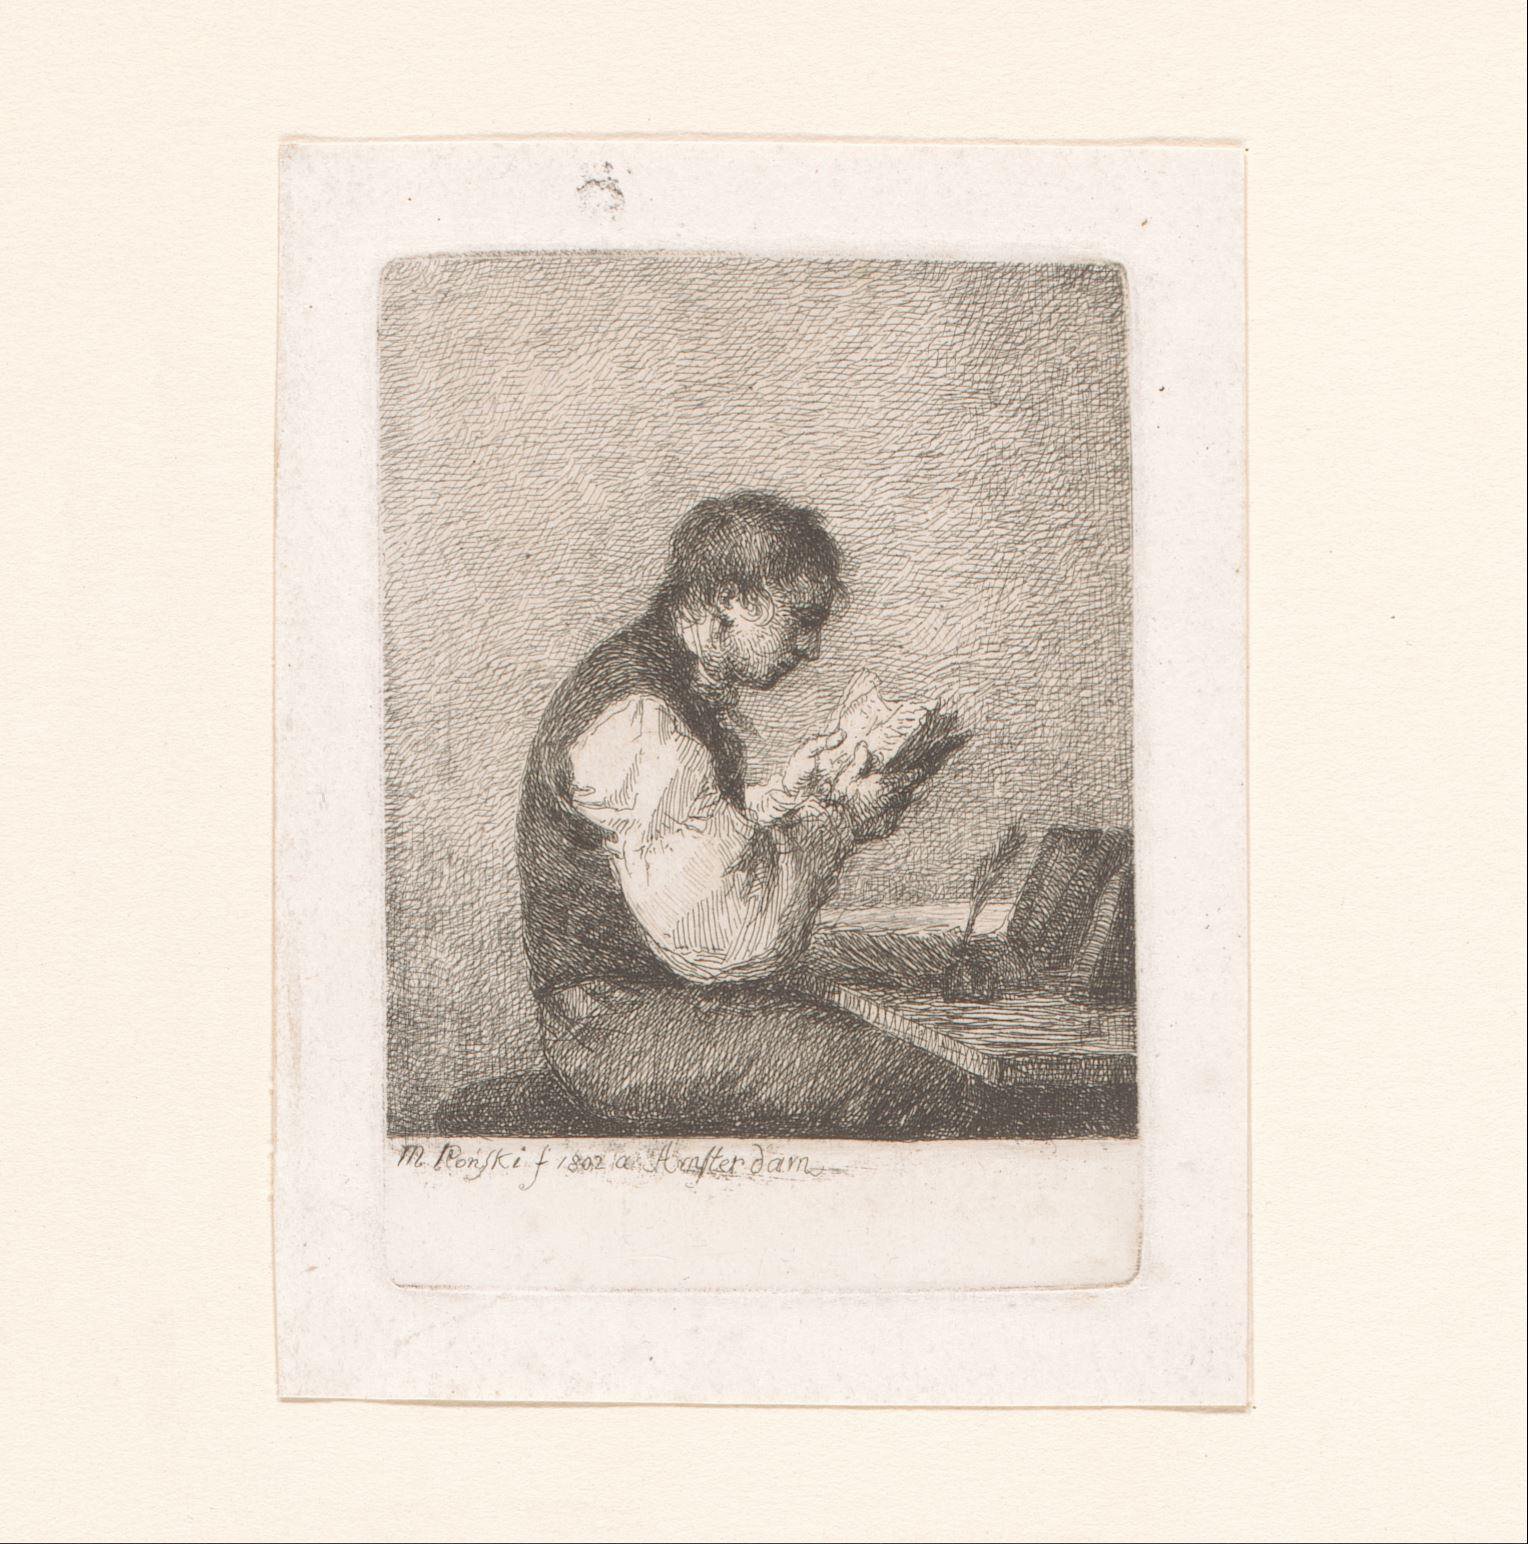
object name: print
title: Veertien etsen van Michał Płoński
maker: michał płoński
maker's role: print maker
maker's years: 1778-1812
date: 1802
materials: paper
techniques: etching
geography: amsterdam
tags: reading, fashion designer, writing accessories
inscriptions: collector's mark: Lugt 2228